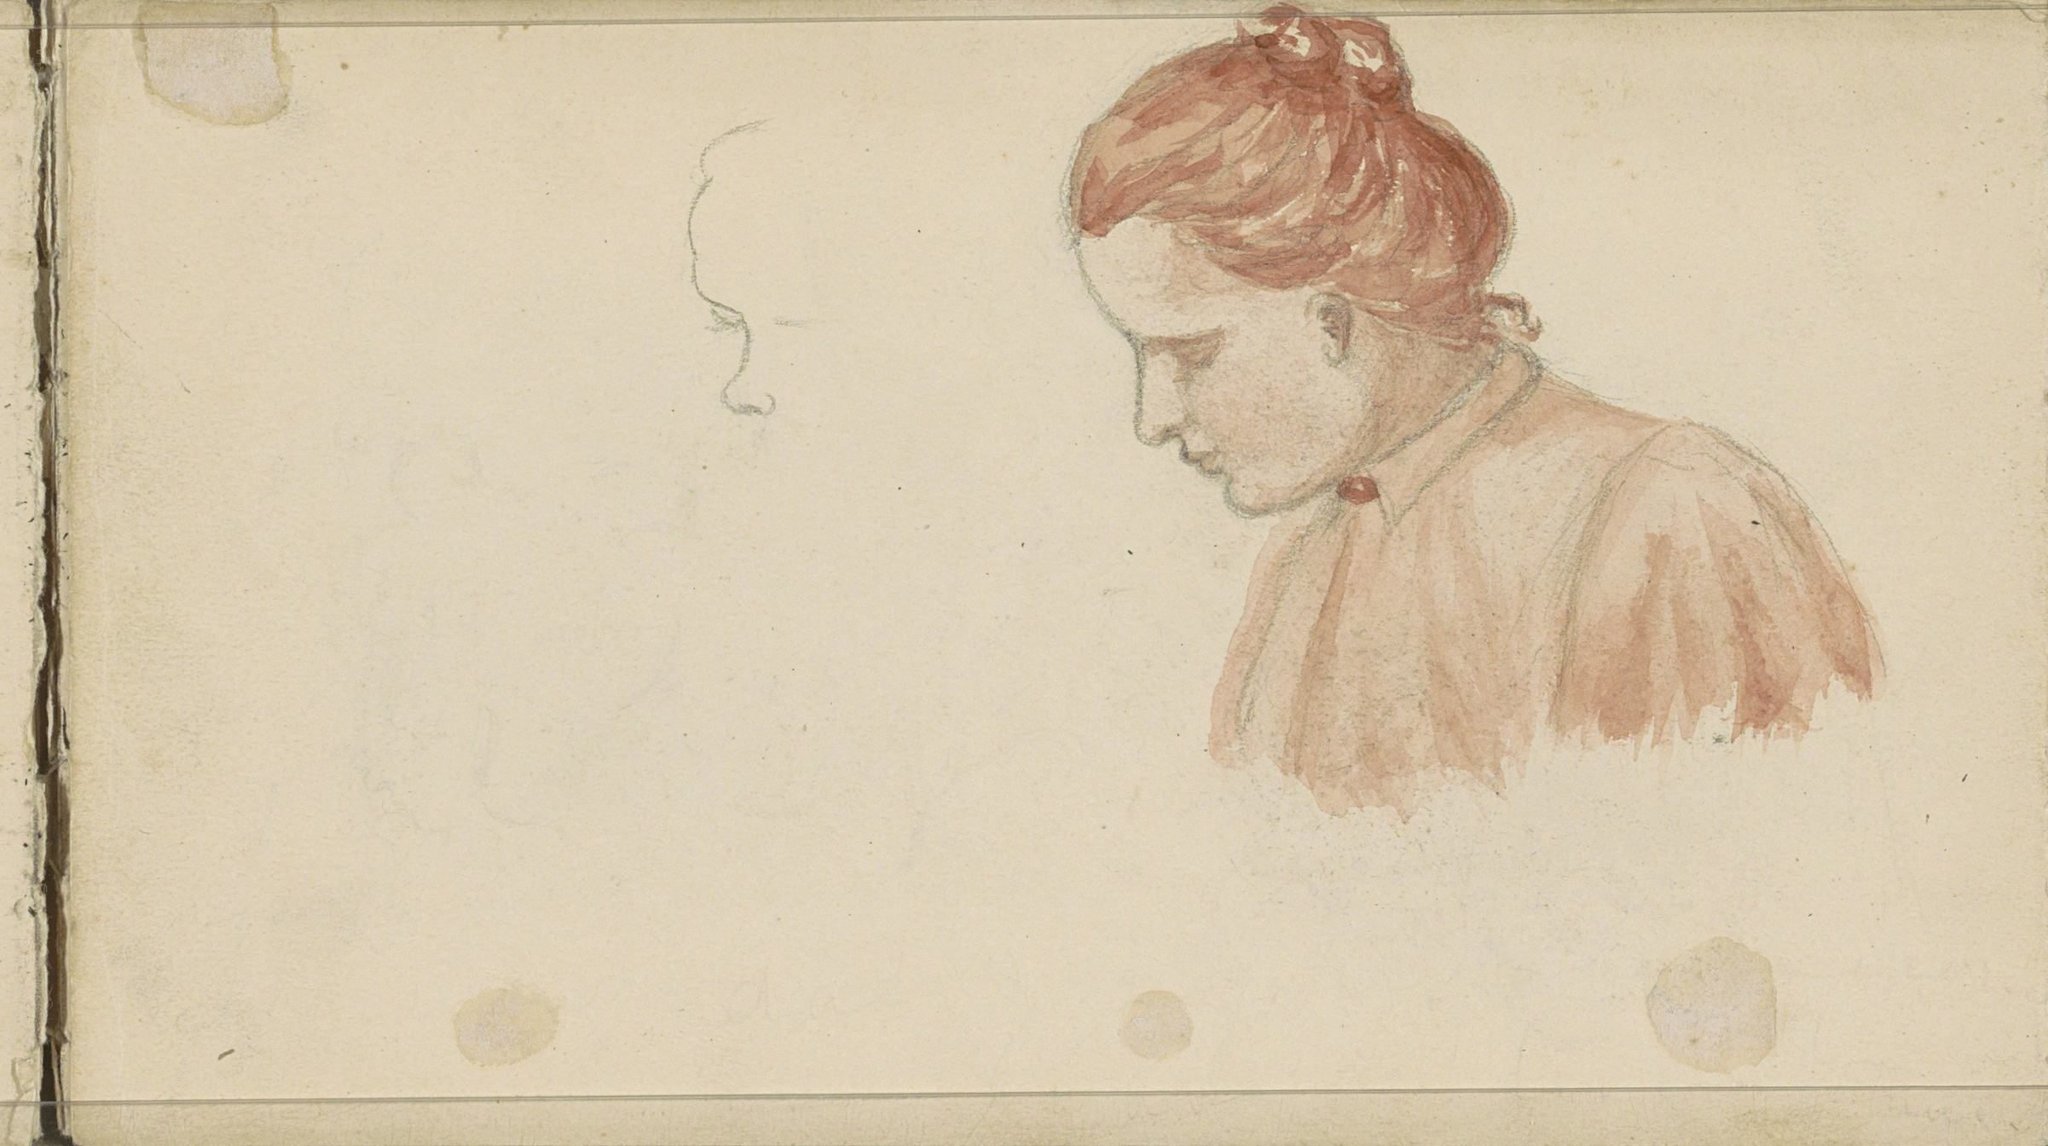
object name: sketchbook leaf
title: Portret van een vrouw met opgestoken haar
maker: julie de graag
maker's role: draughtsman, print maker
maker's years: 1877-1924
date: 1892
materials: paper, pencil, watercolor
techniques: brush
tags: head (human), adult woman, clothing for the upper part of the body: blouse (+ women's clothes)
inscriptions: annotation: ‘Tuus.’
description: Tevens een studie van het profiel (voorhoofd en neus) van de vrouw. Blad 8 recto uit een schetsboek met 22 bladen.